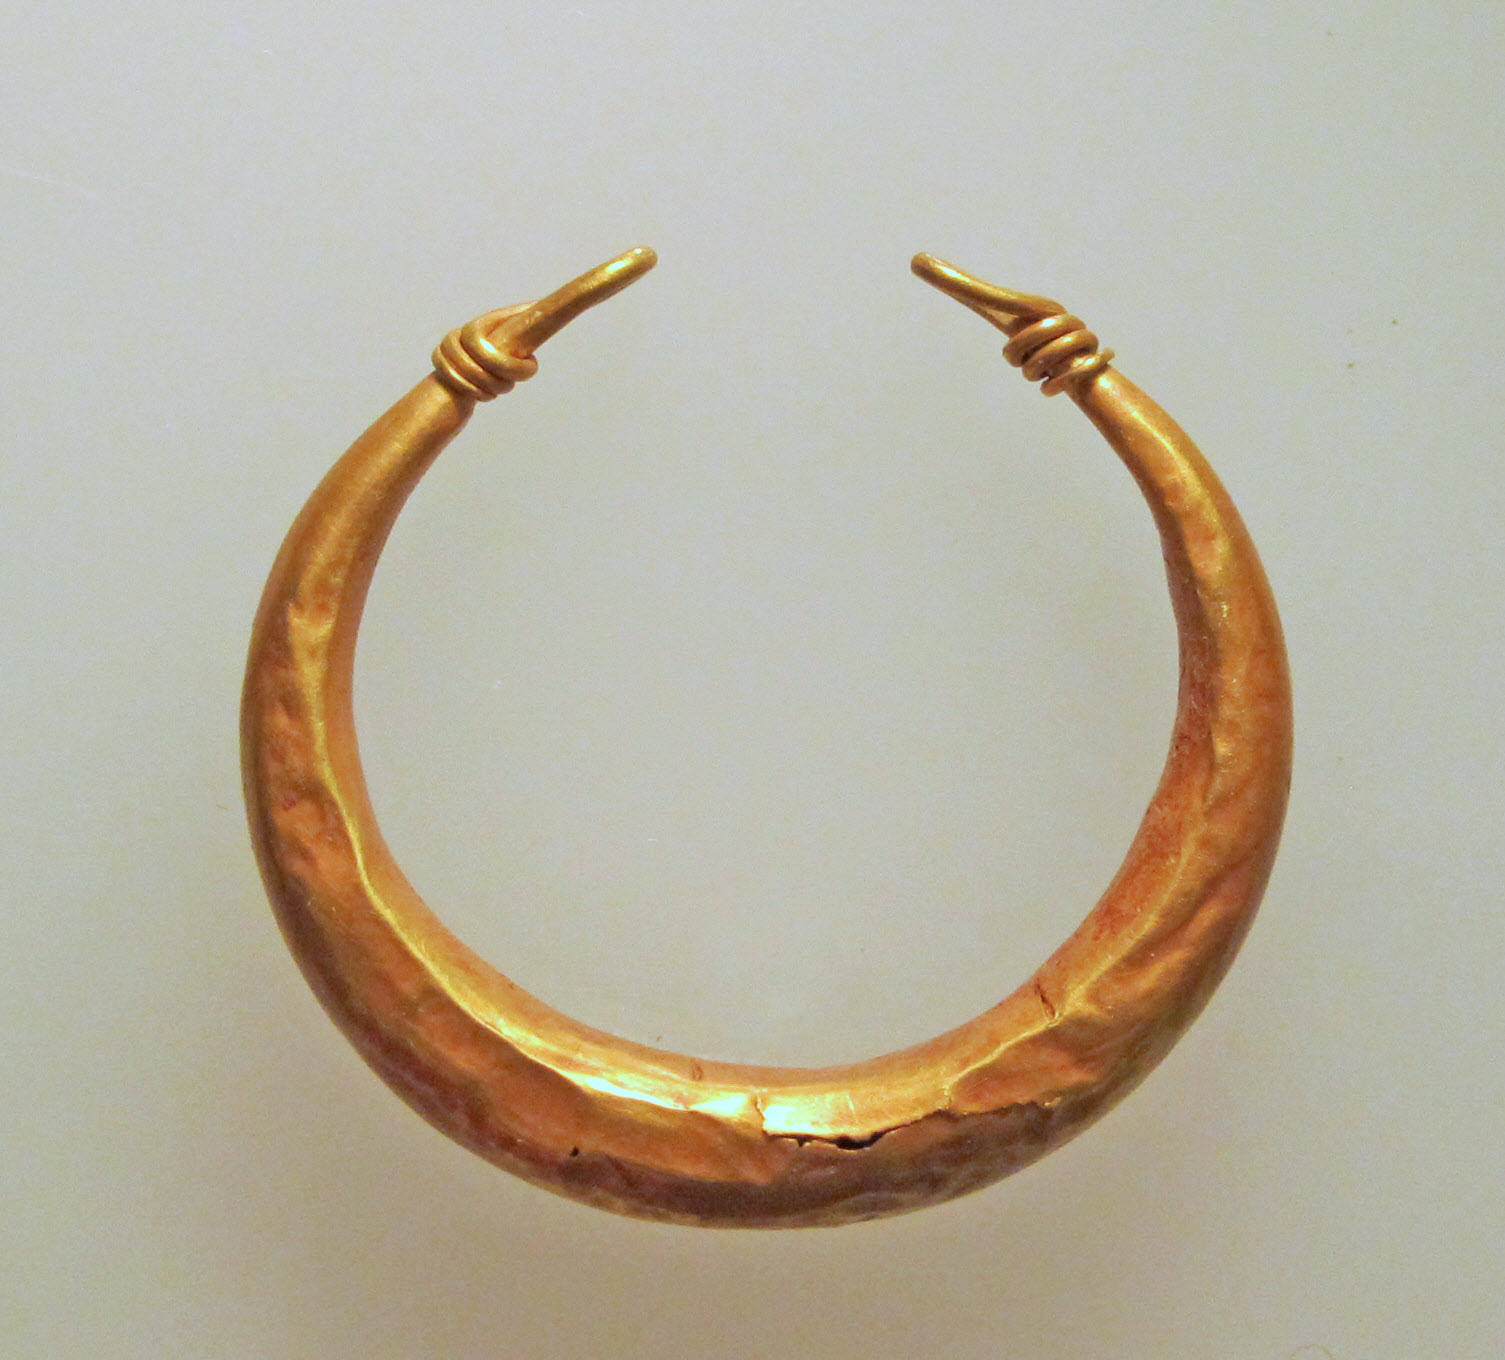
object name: earring of simple form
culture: cypriot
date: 3900 BCE-100 CE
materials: gold